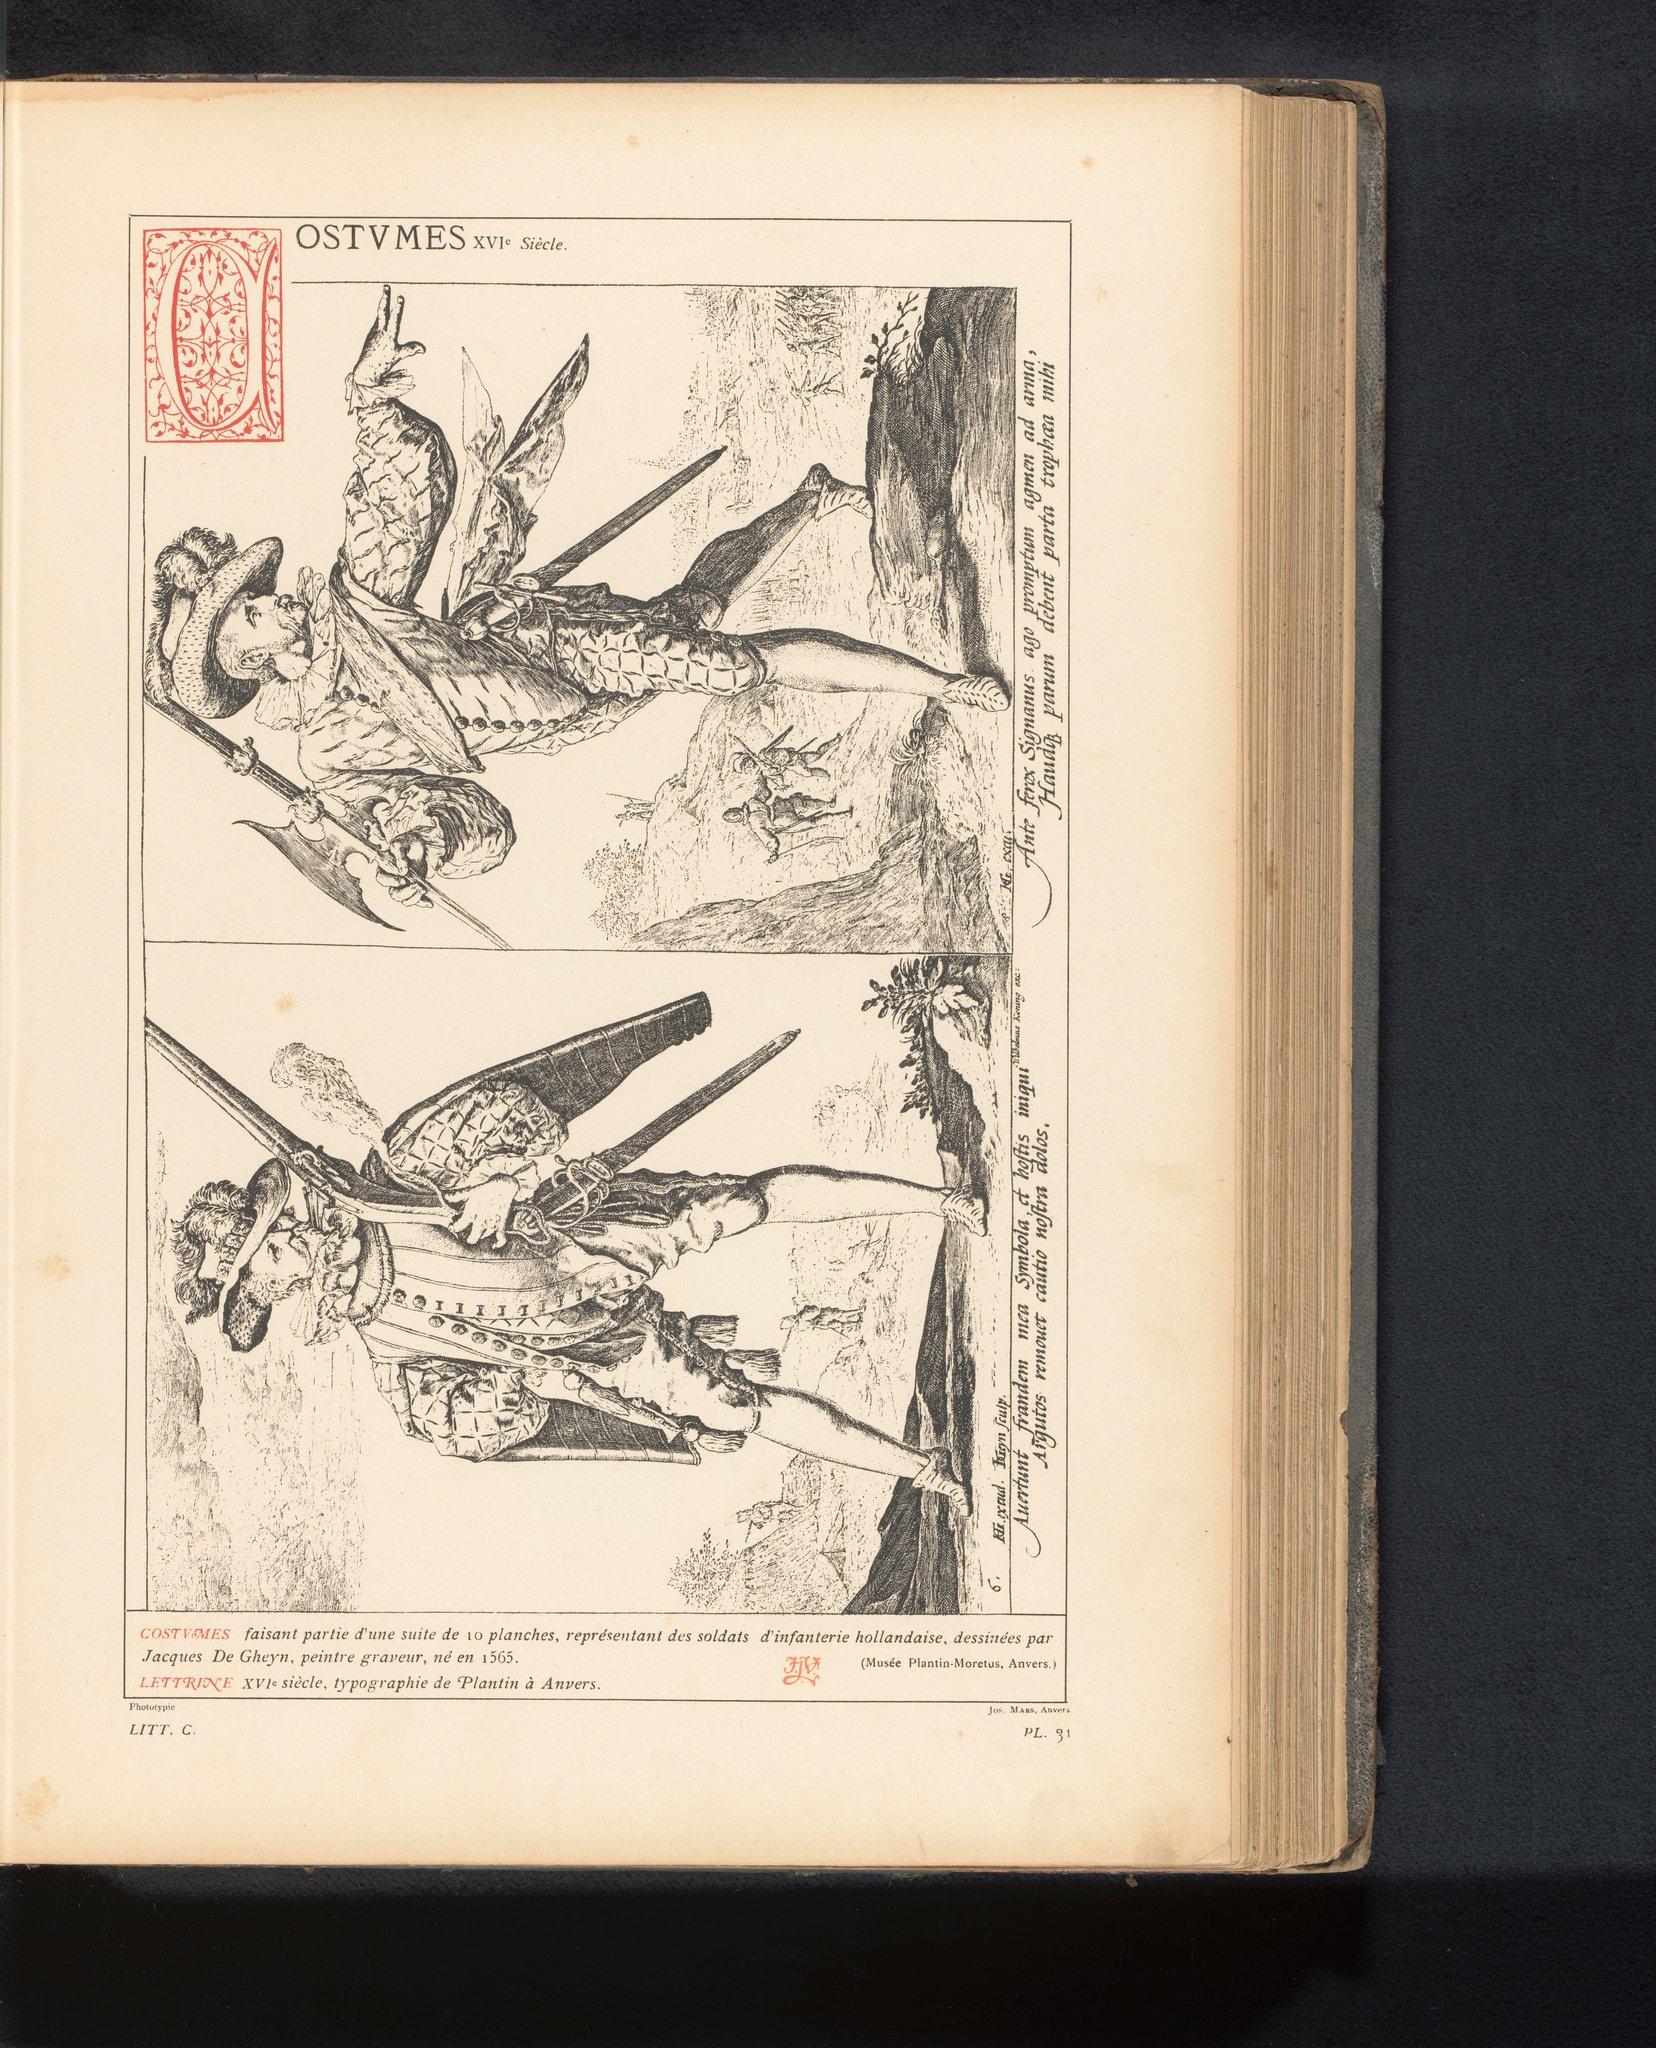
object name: photomechanical print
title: Reproductie van twee kostuumprenten van Nederlandse infanteristen door Jacques de Gheyn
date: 1875-1880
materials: paper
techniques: photolithography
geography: antwerp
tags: (military) uniforms (+ infantry)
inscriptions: inscription: ‘LITT: C. - PL. 31’, monogram: ‘JJvY’, inscription: ‘Costumes faisant partie (...)’